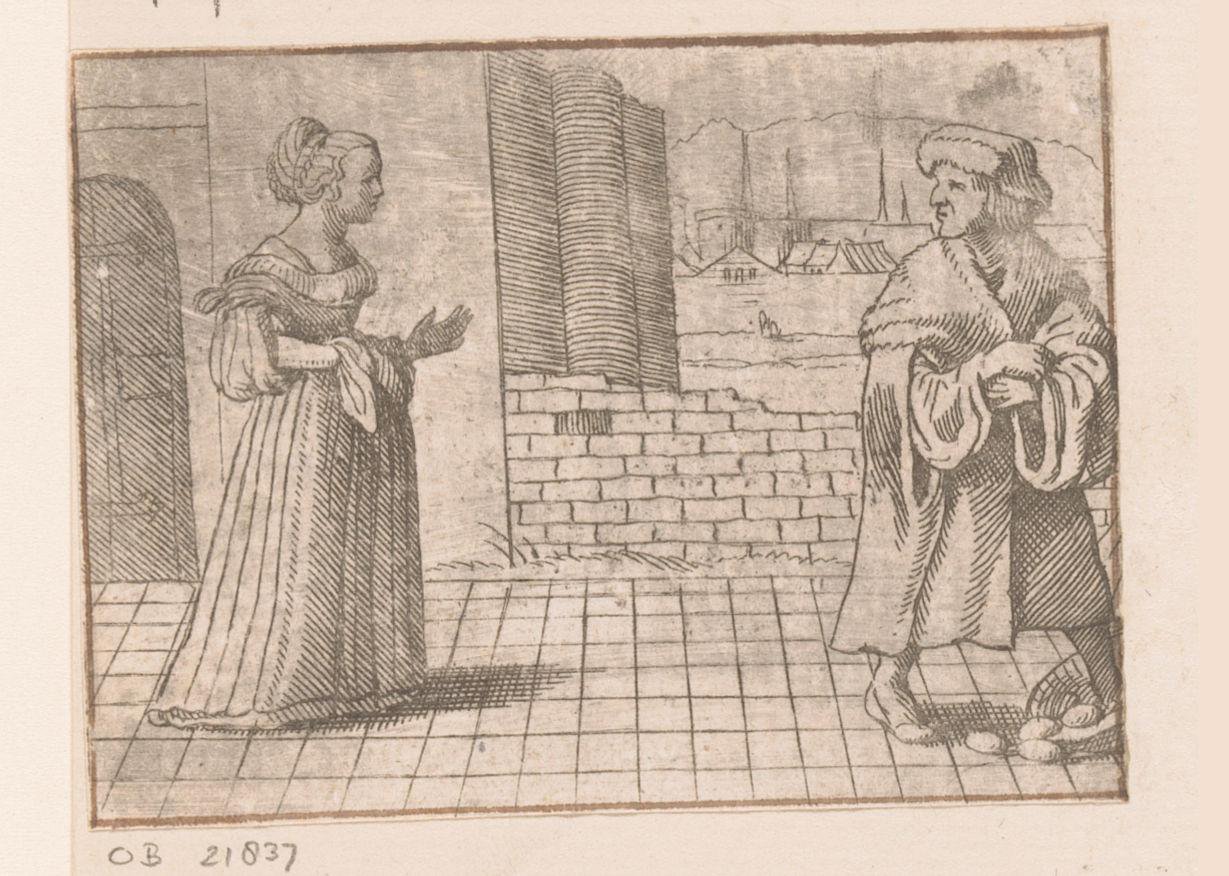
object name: print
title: Illustraties uit de Lof der Zotheid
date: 1516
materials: paper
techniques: etching, letterpress printing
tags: desiderius erasmus, folly, foolishness; 'pazzia', 'sciocchezza', 'stoltitia' (ripa), lovers; courting, flirting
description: Prent afkomstig uit: Erasmus, Desiderius. Morias enkomion (...). Bazel: Johann Rudolf Genath, 1676. De prenten hierin zijn naar tekeningen die Hans en Ambrosius Holbein maakten voor de theoloog Oswald Myconius in diens uitgave van de Moriae encomium (Lof der Zotheid) van 1516.